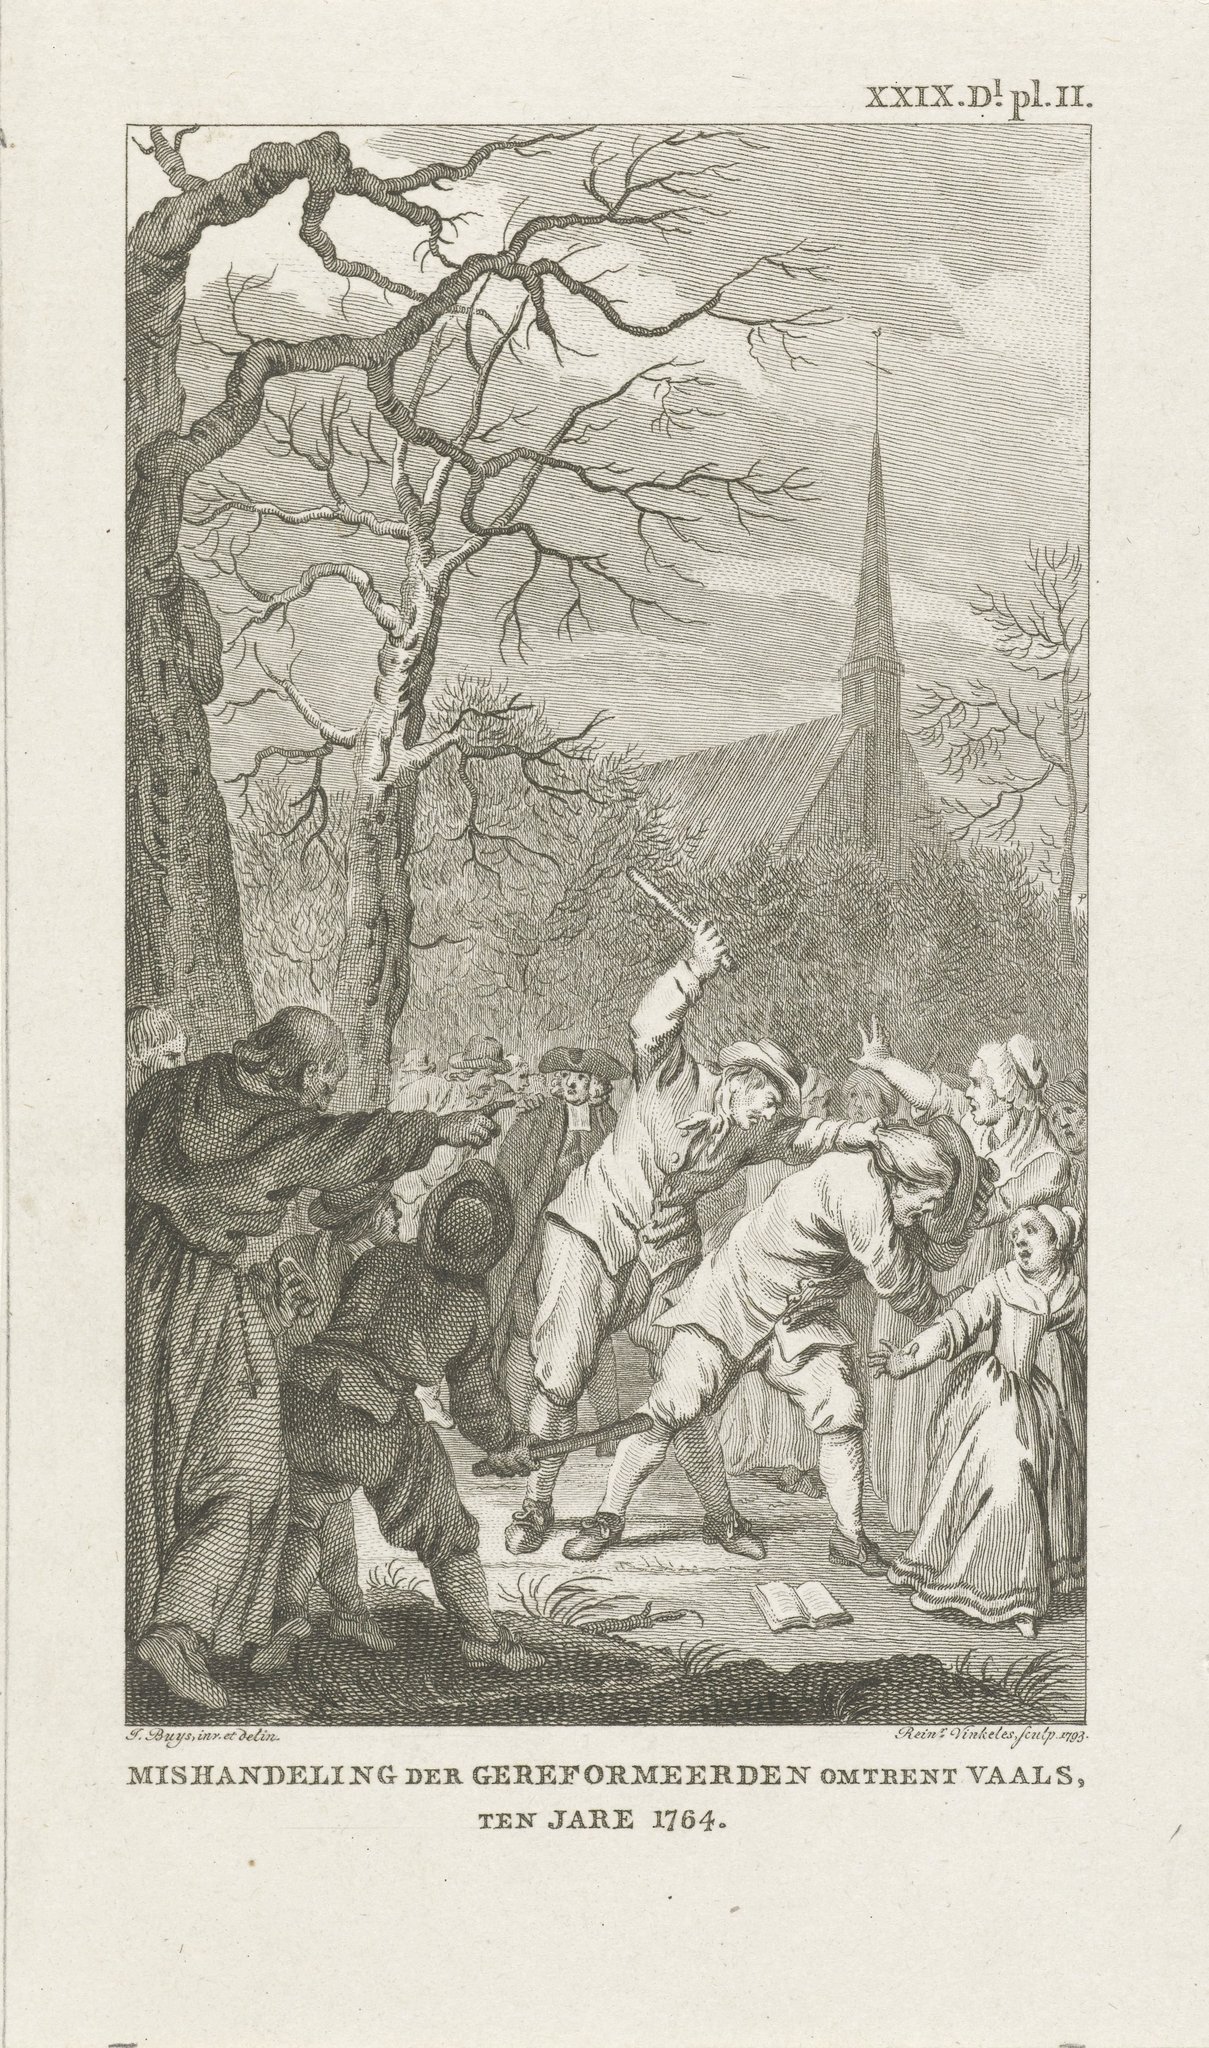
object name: history print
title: Mishandeling der Gereformeerden omtrent Vaals, ten Jare 1764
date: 1793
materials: paper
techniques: engraving, etching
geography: northern netherlands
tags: persecution of believers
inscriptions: collector's mark: Lugt 2228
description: Mishandeling van gereformeerden door katholieken te Vaals en in drie andere nabij gelegen dorpen, januari 1764. Een roomse priester moedigt aan tot de mishandeling. Gemerkt rechtsboven: XXIX. Dl. pl. II.